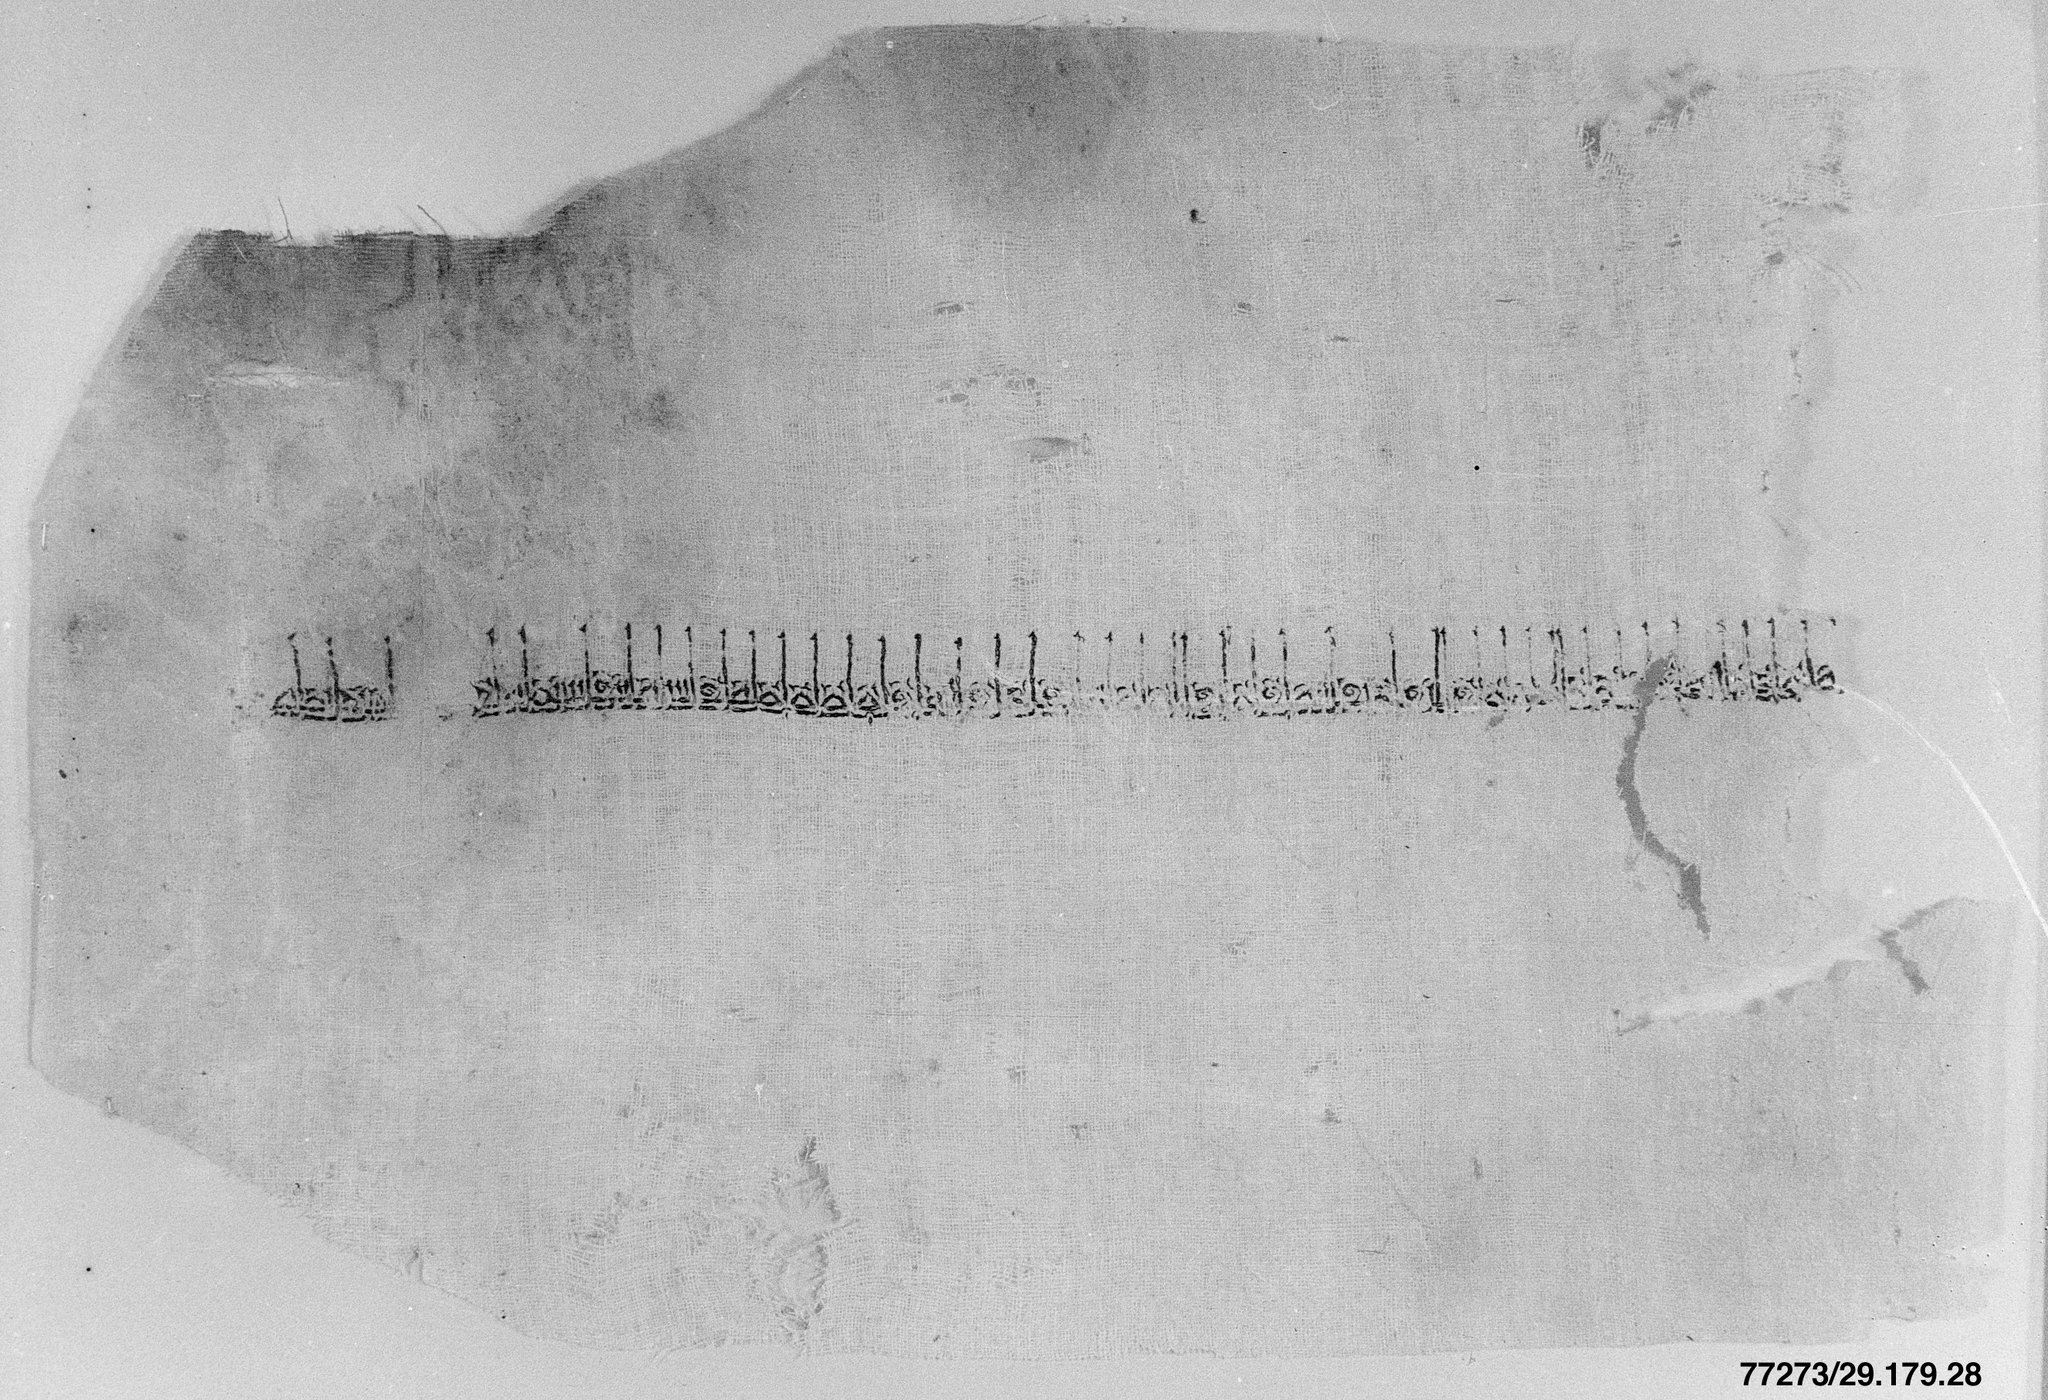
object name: textile fragment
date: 901-1000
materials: linen, silk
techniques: embroidery, weave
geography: egypt